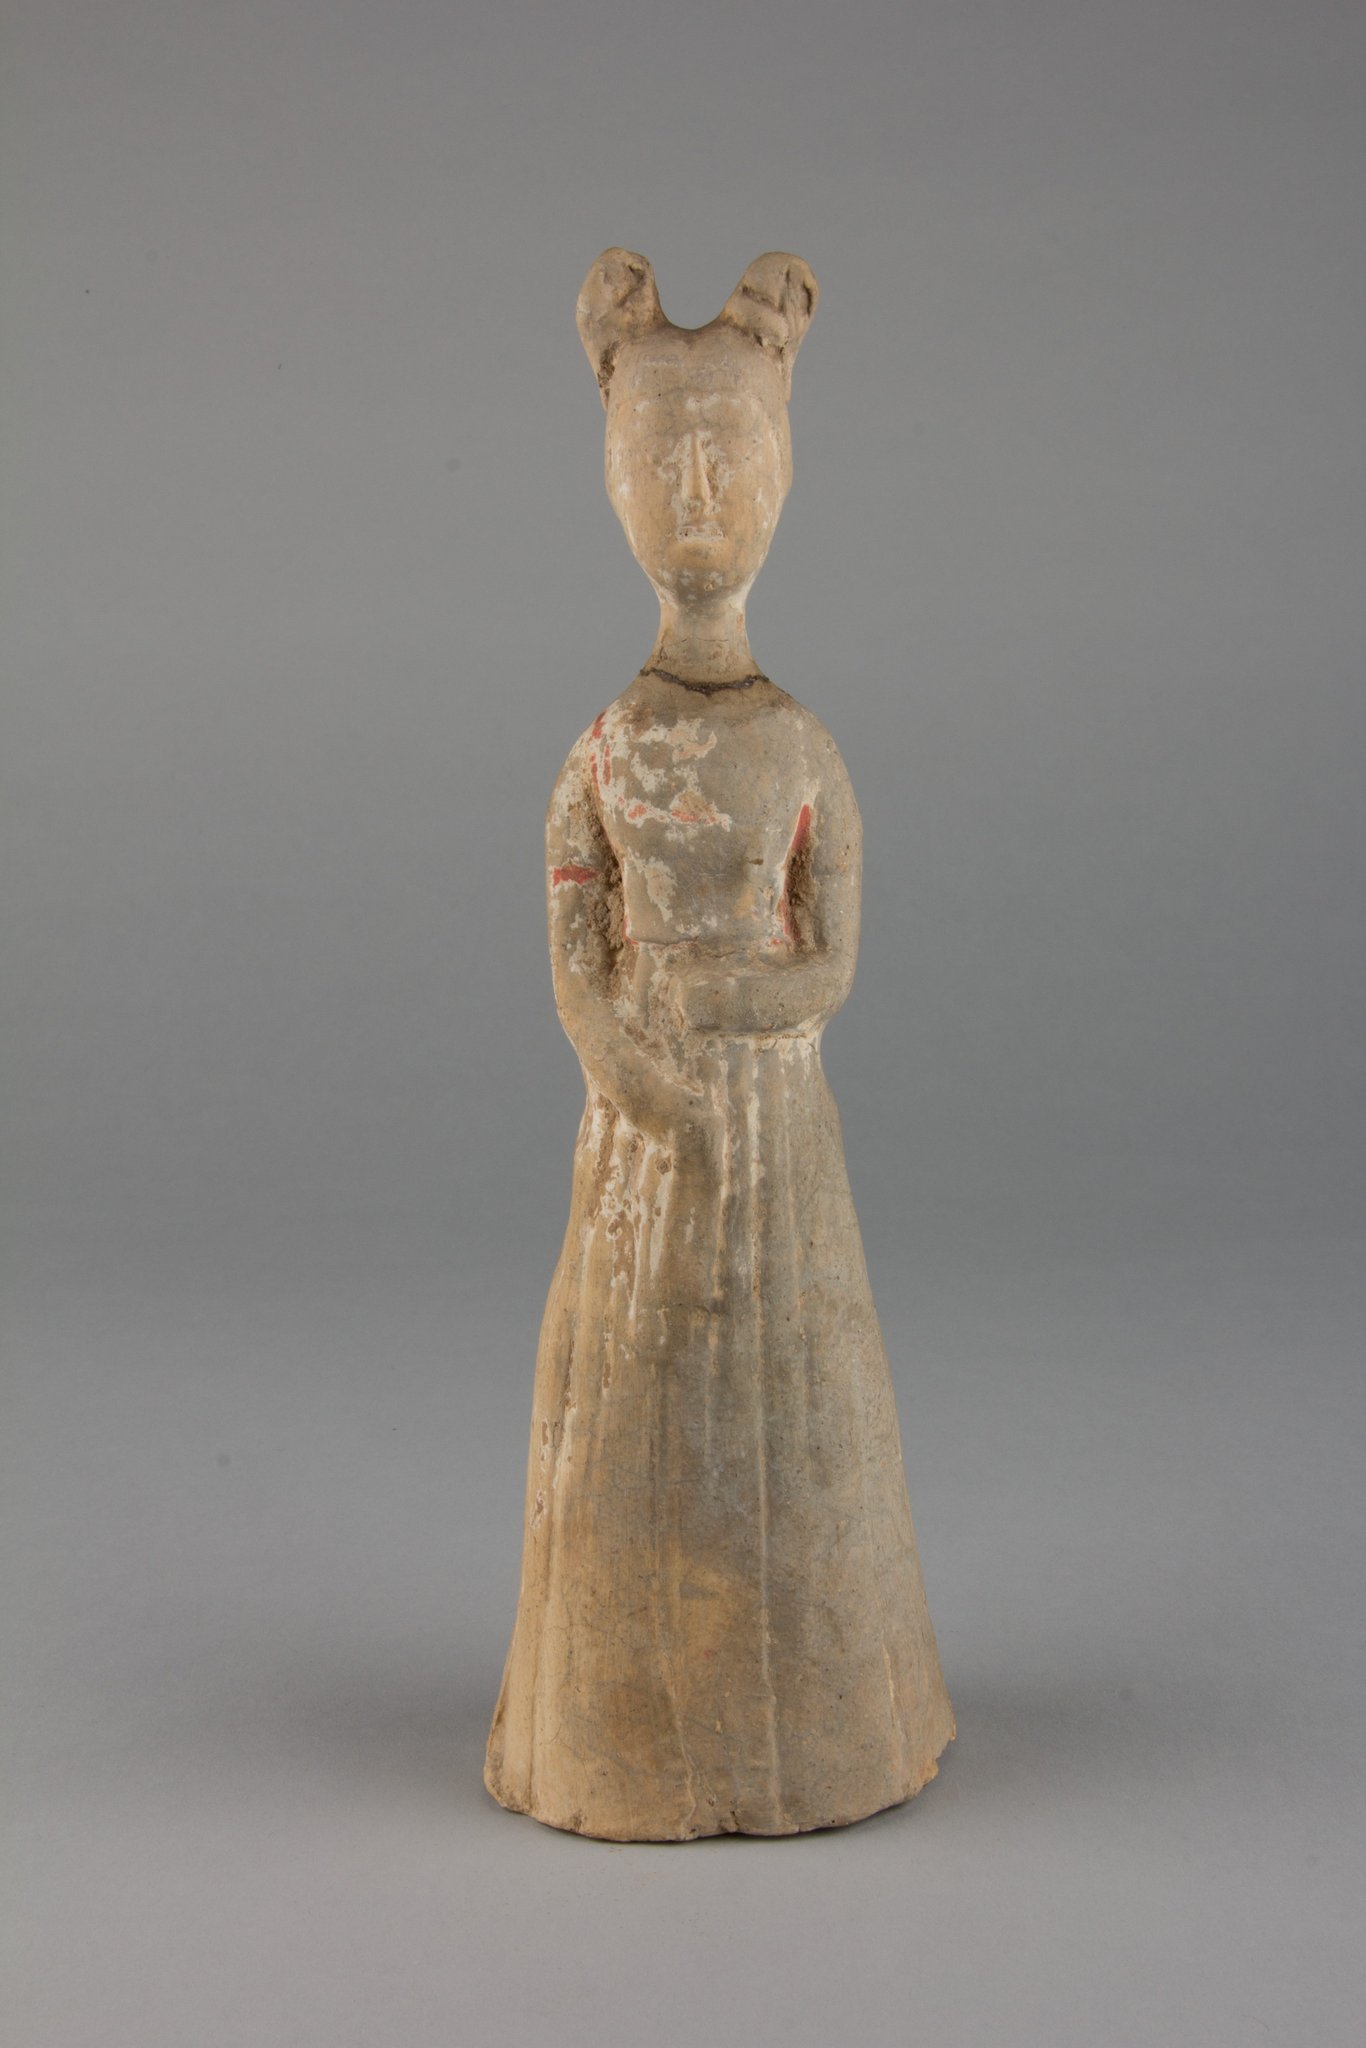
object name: figure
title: Figure of a standing woman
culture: chinese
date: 601-800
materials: earthenware, pigment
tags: women